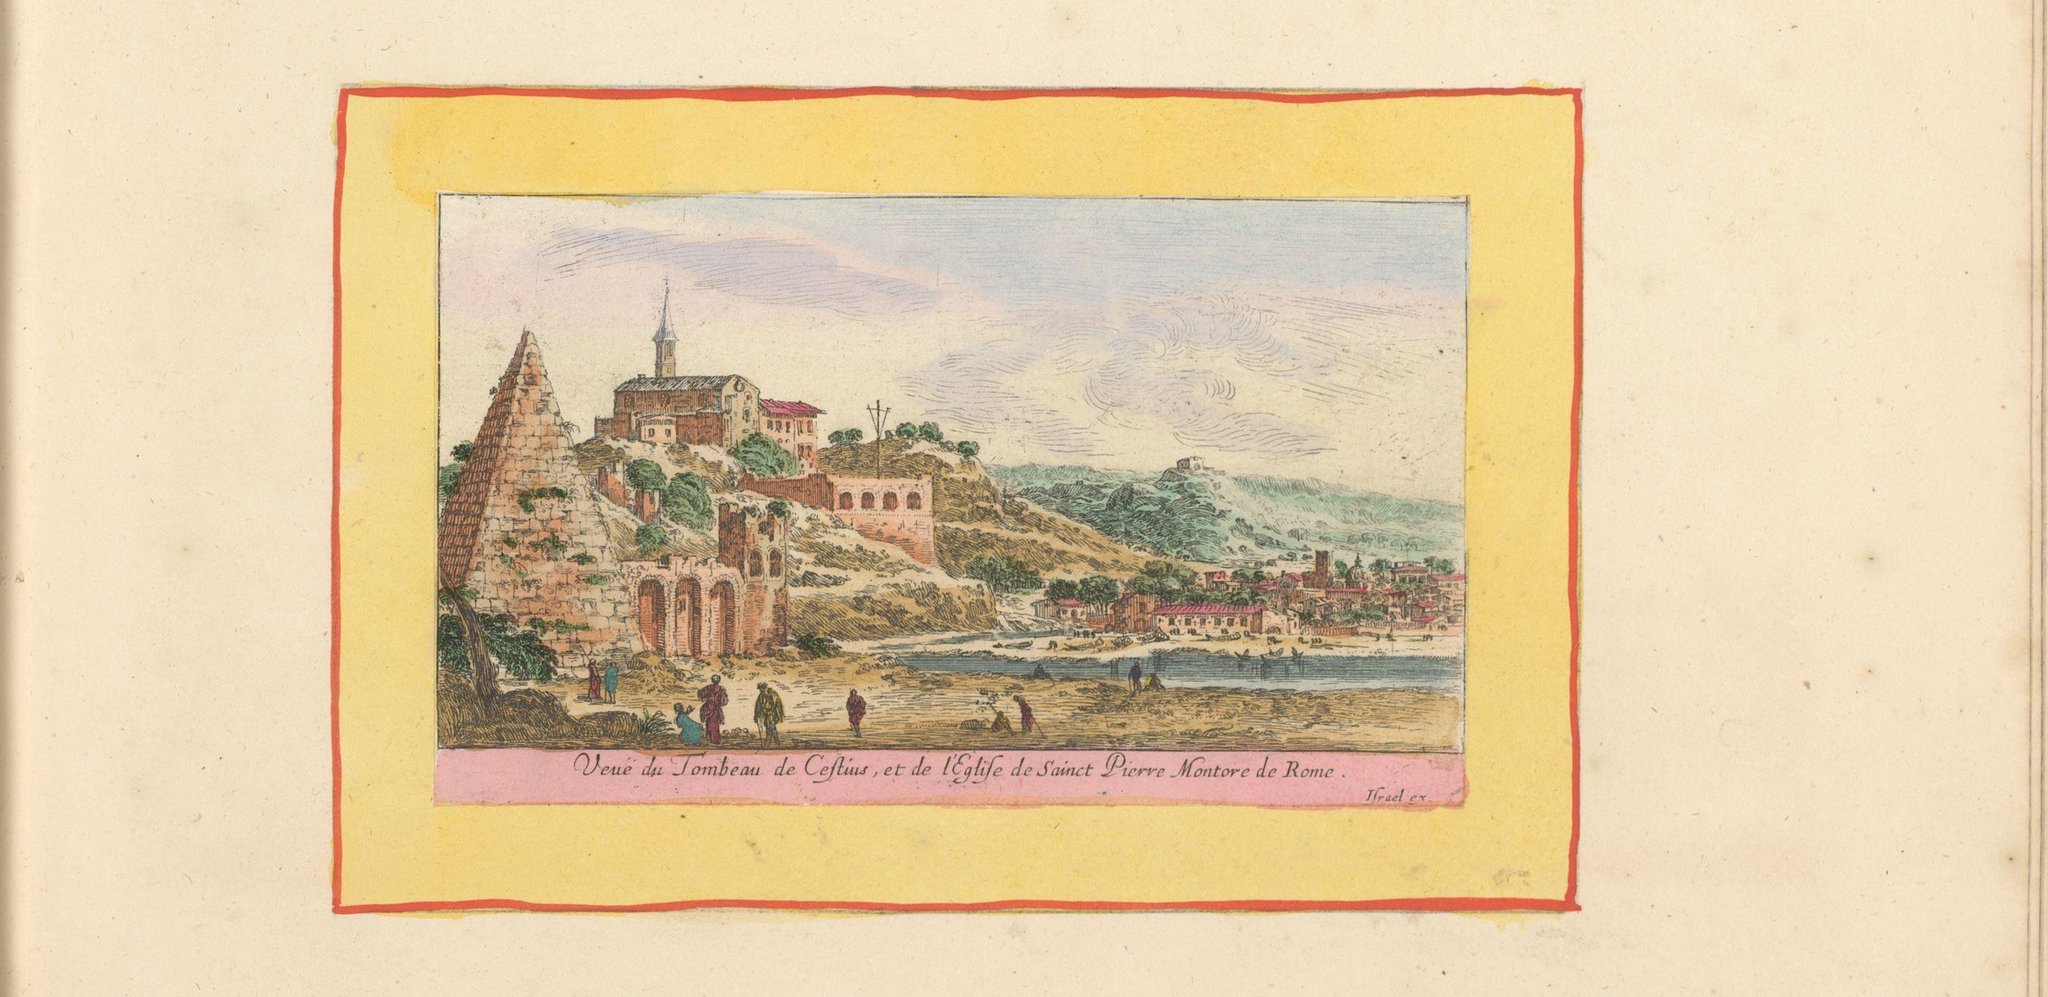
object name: album leaf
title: Gezichten op Italiaanse steden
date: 1631-1691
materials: paper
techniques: colour, etching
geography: the hague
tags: city-view, and landscape with man-made constructions, church (exterior), pyramid (marking grave)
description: Gezicht op de Piramide van Cestius en de San Pietro in Montorio te Rome. Titel in het Frans in de ondermarge. Prent maakt deel uit van een album.